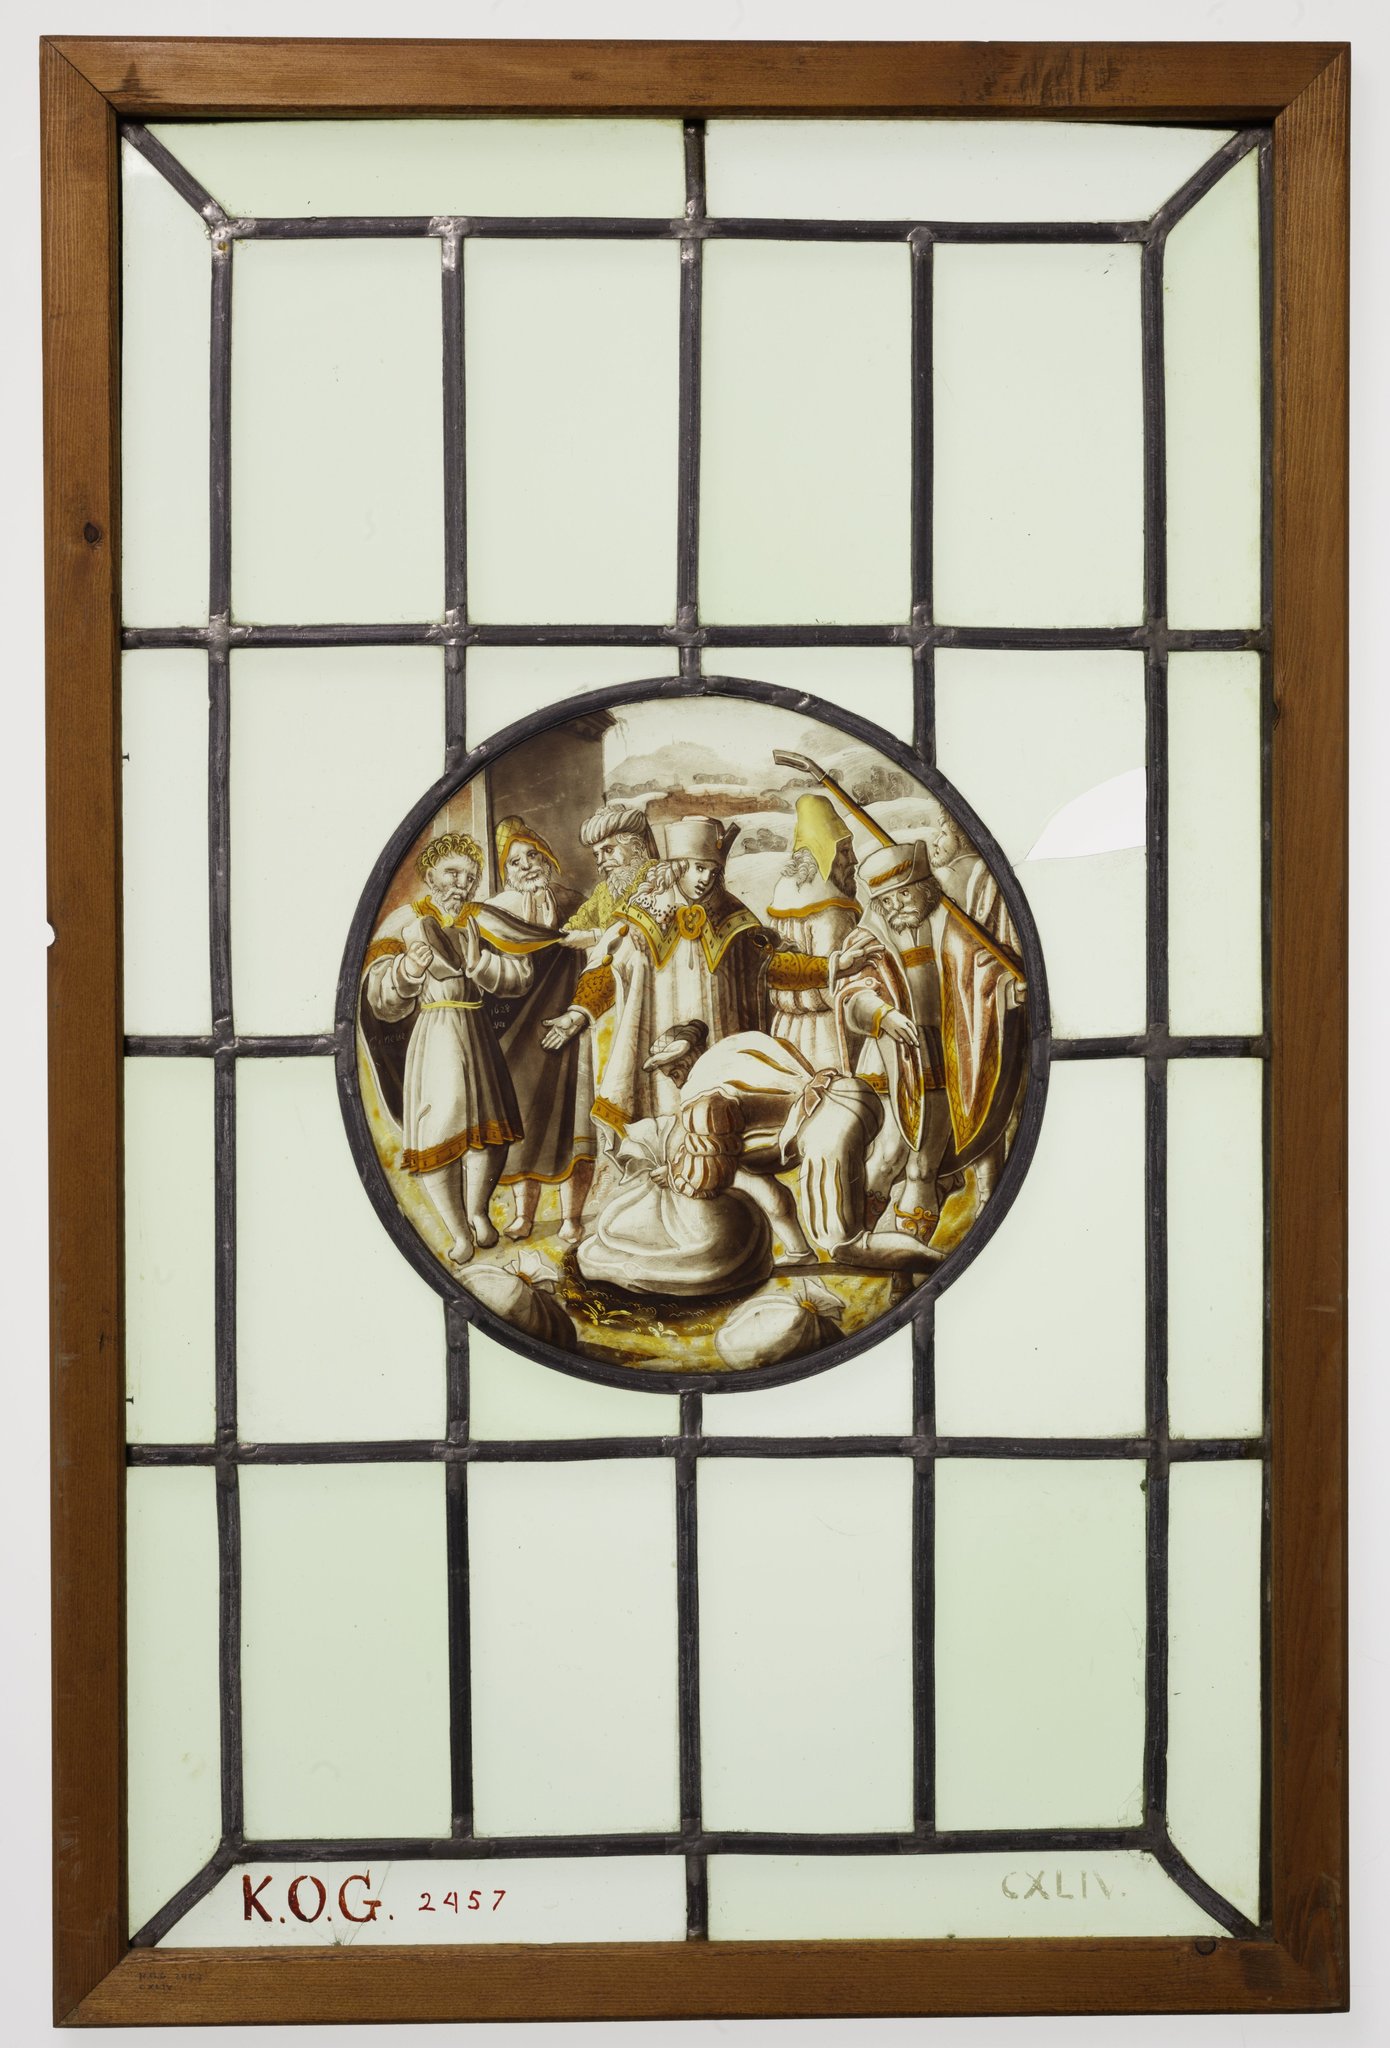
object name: light window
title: Ruit met Jozef zich aan de broeders bekend makende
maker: Anonymous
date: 1550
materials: glass, lead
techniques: leading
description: Ruit met Jozef zich aan de broeders bekend makende